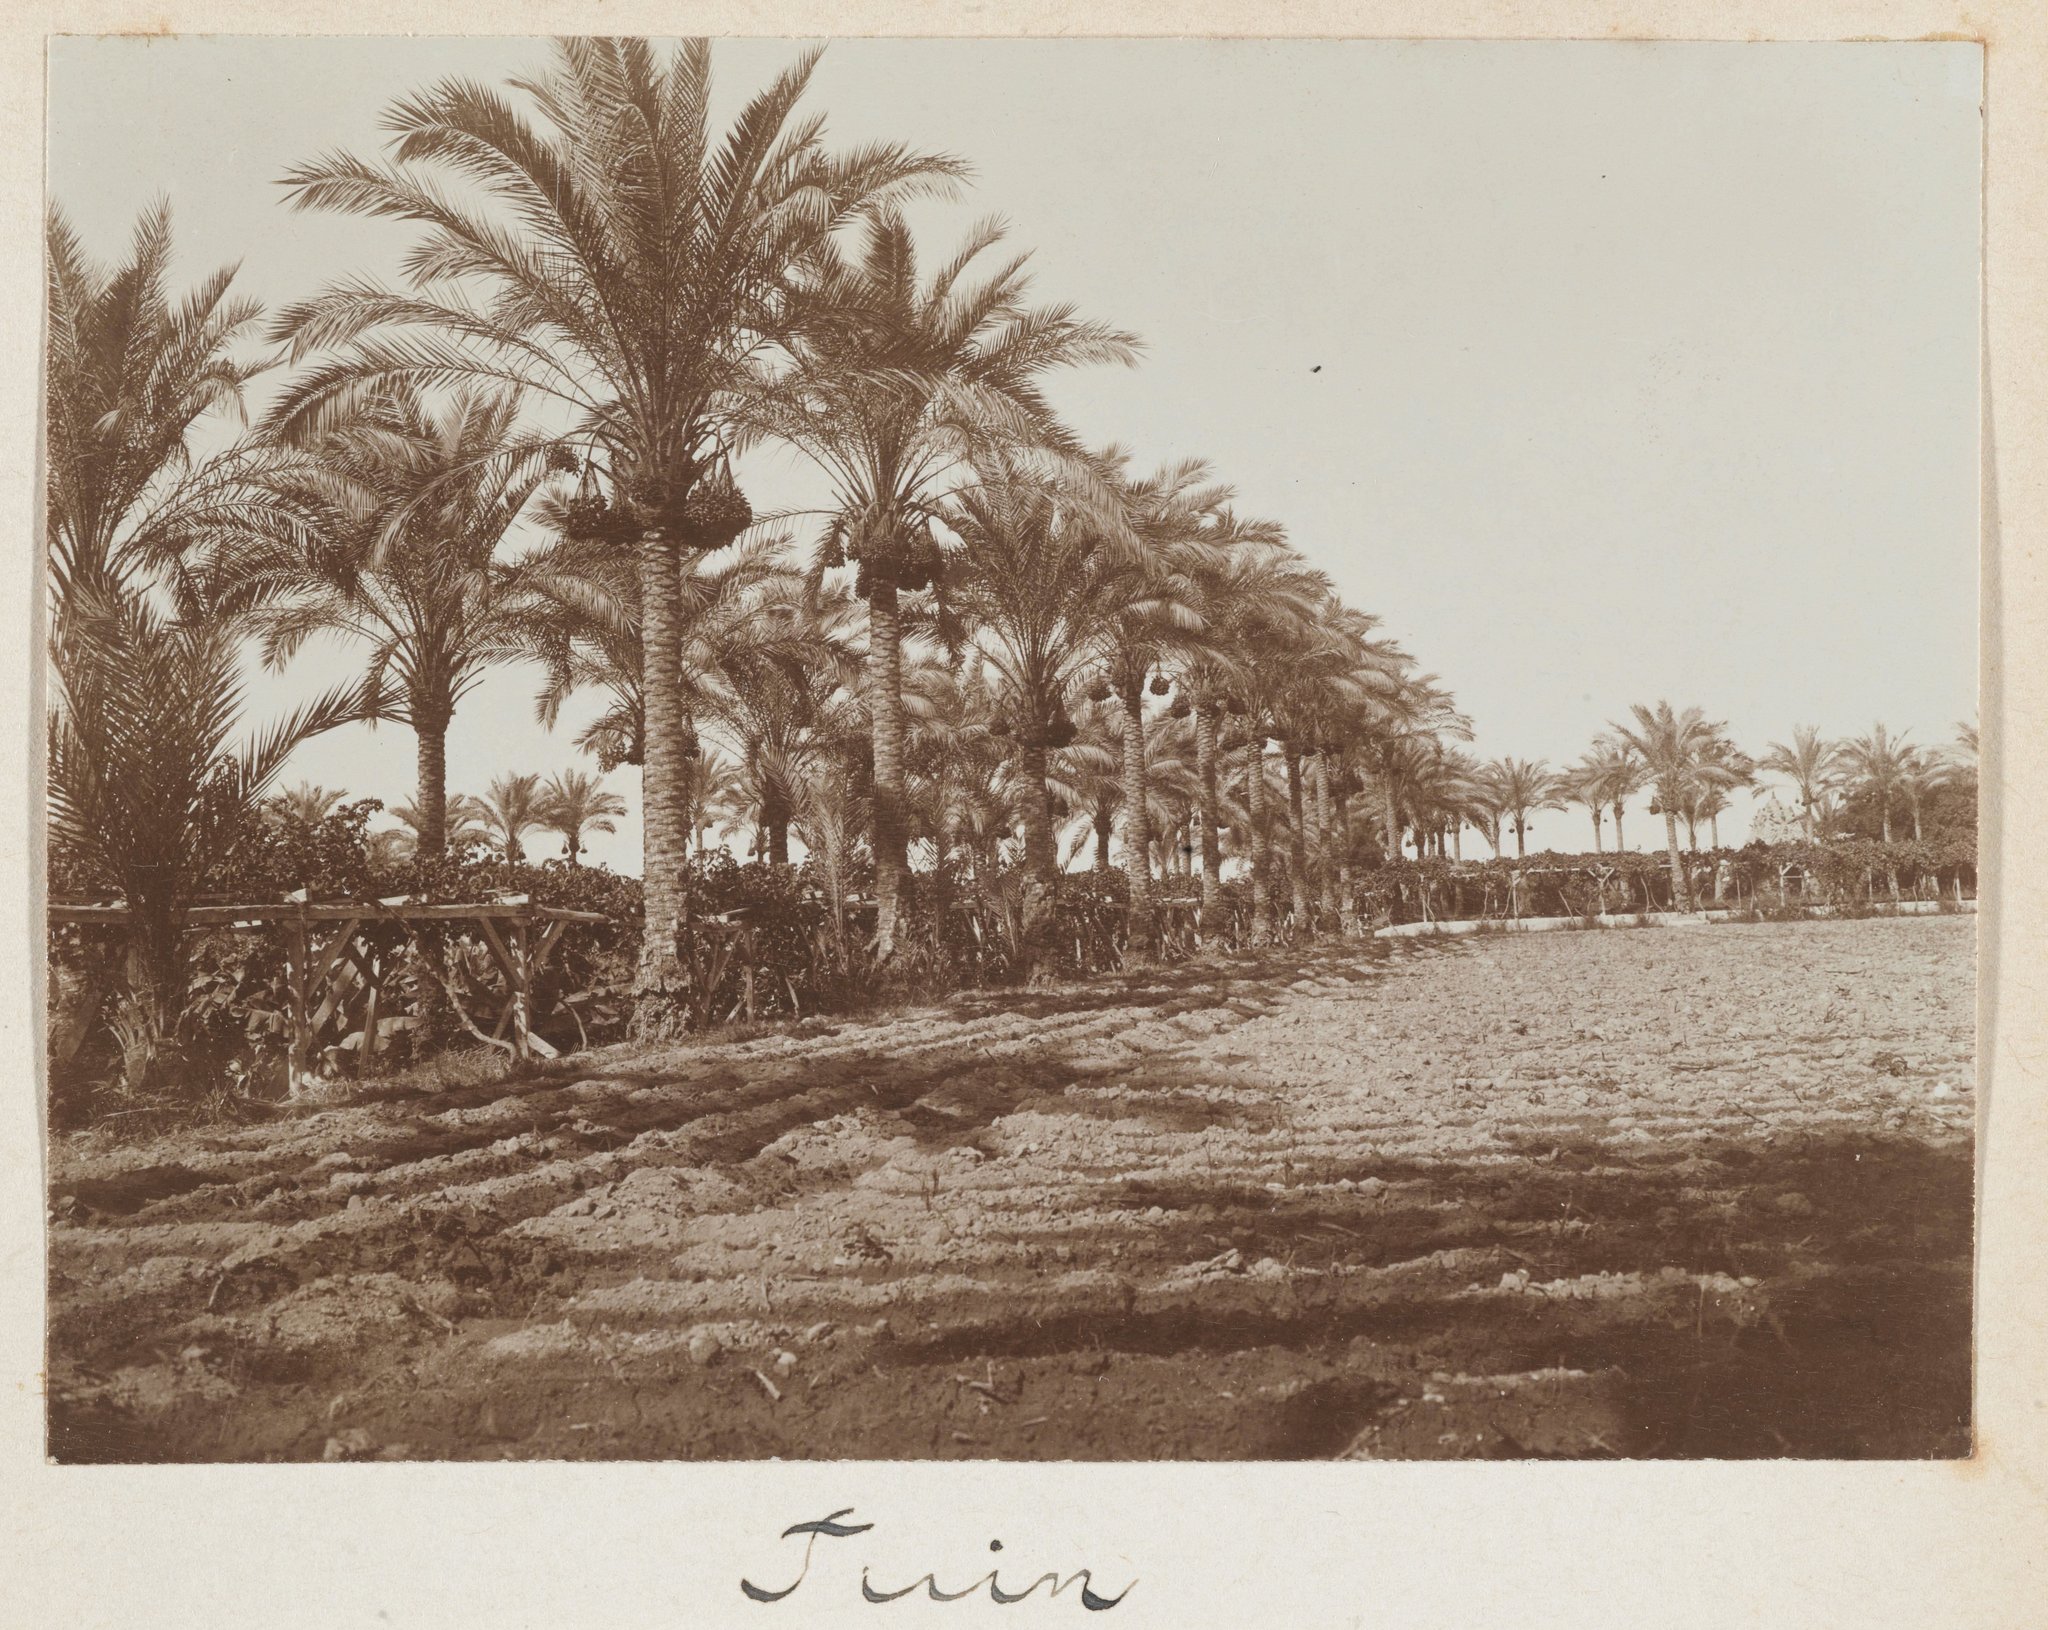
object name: photograph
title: Palmentuin van een buitenverblijf in Alexandrië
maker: johannes lodewijk heldring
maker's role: fotograaf, predikant, schrijver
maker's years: 1852-1923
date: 1898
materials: paper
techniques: collodion silver print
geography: alexandria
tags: trees: palm-tree